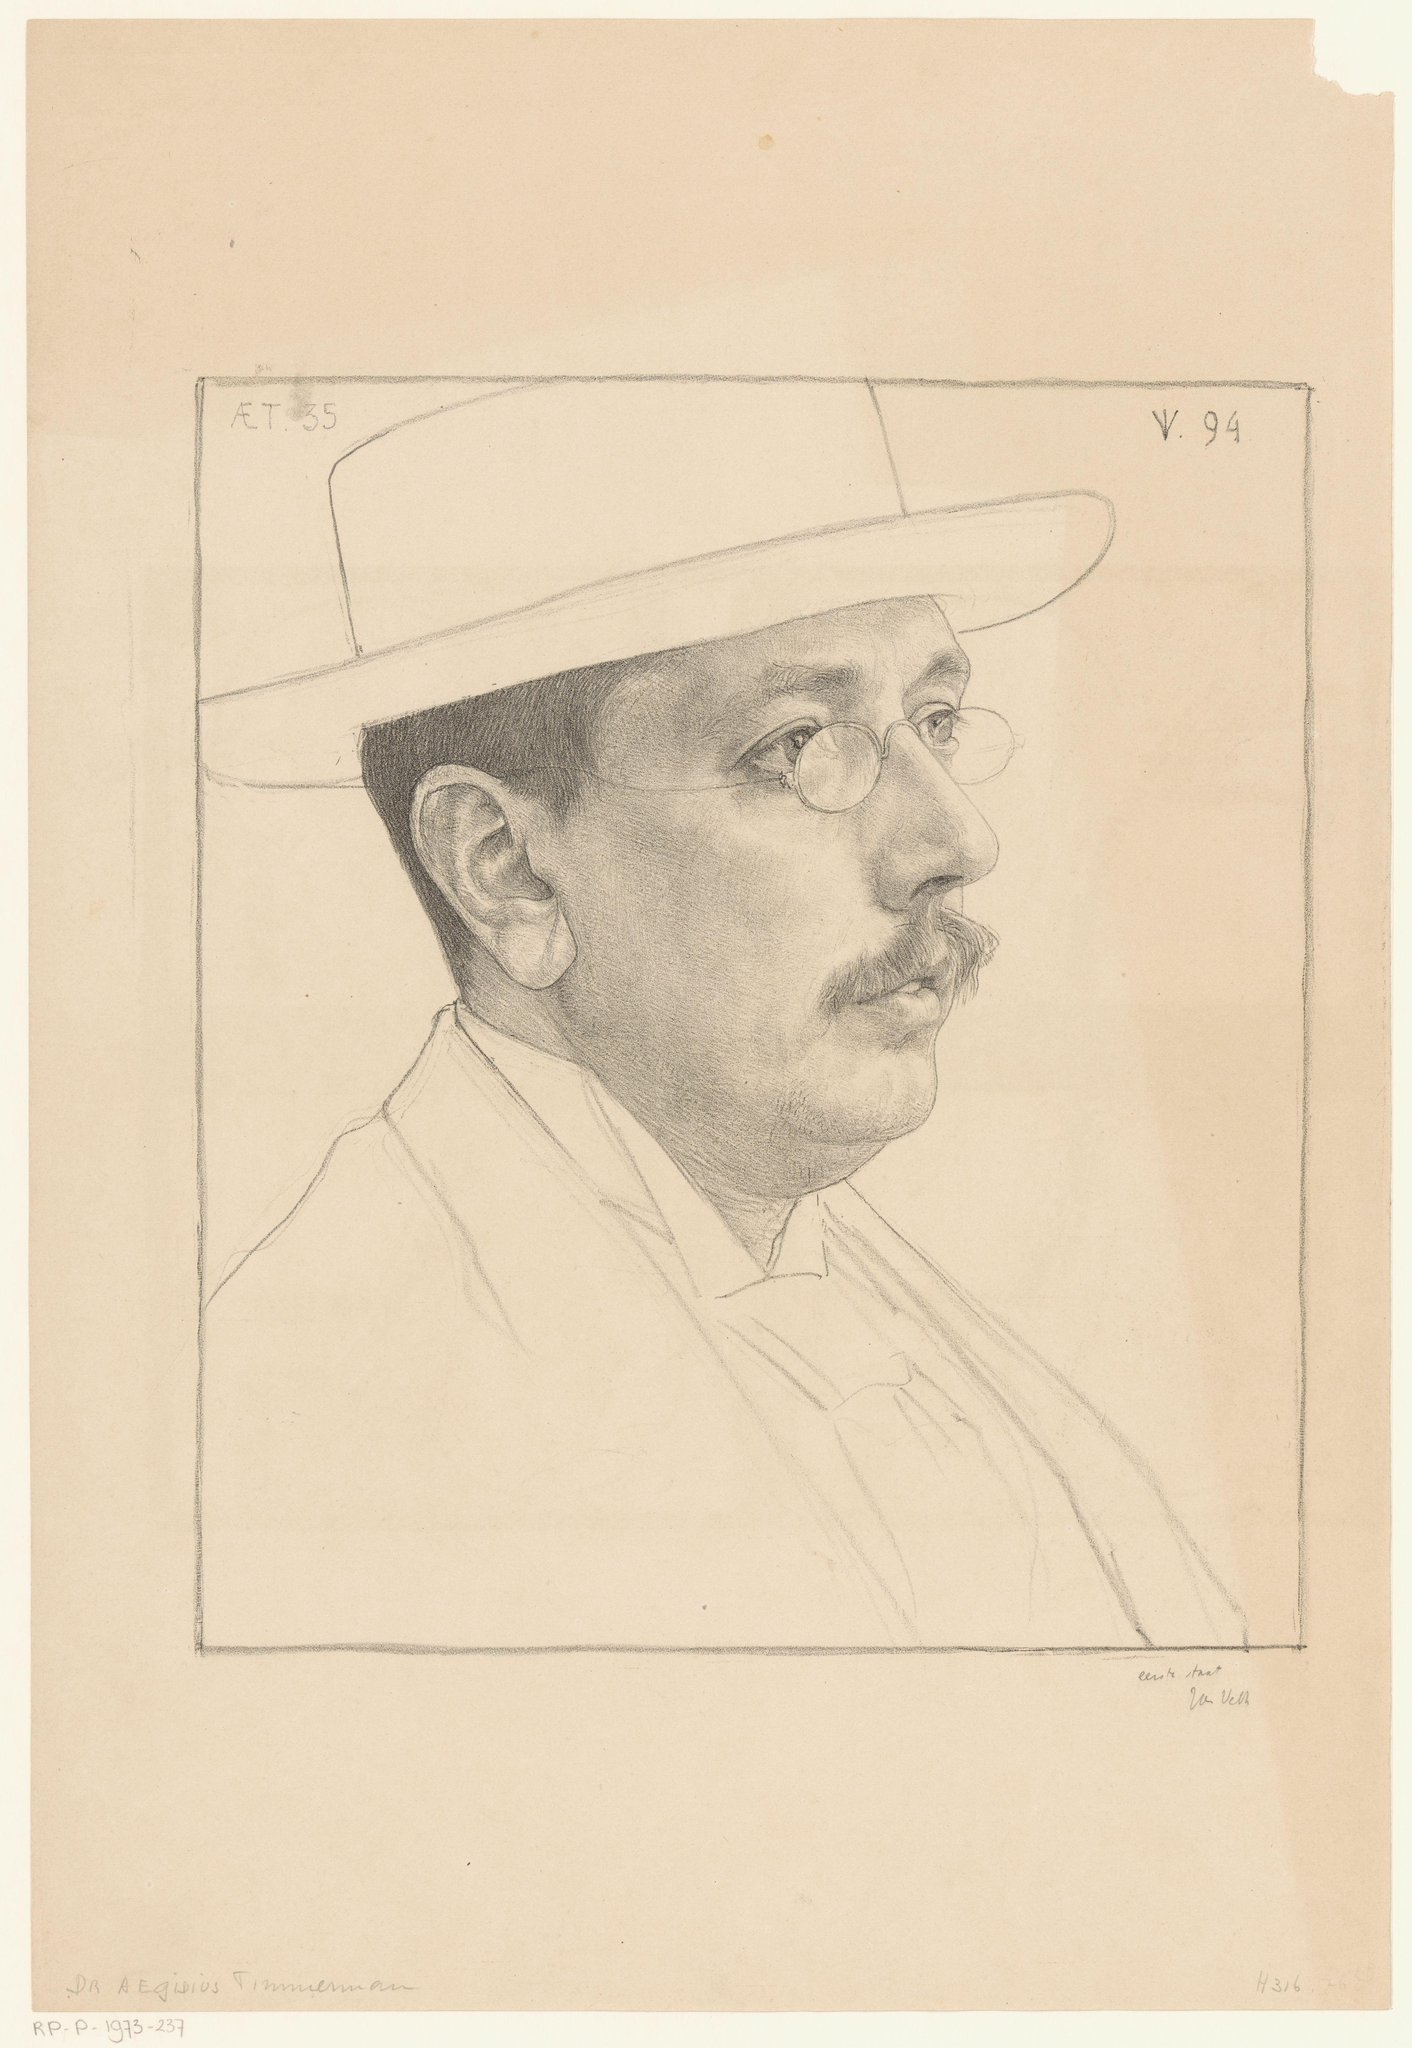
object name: print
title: Portret van Aegidius Willem Timmerman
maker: jan veth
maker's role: designer, draughtsman, painter, print maker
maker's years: 1864-1925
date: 1894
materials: paper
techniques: lithograph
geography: netherlands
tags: aegidius willem timmerman, historical persons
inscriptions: inscription: ‘eerste staat / Jan Veth’